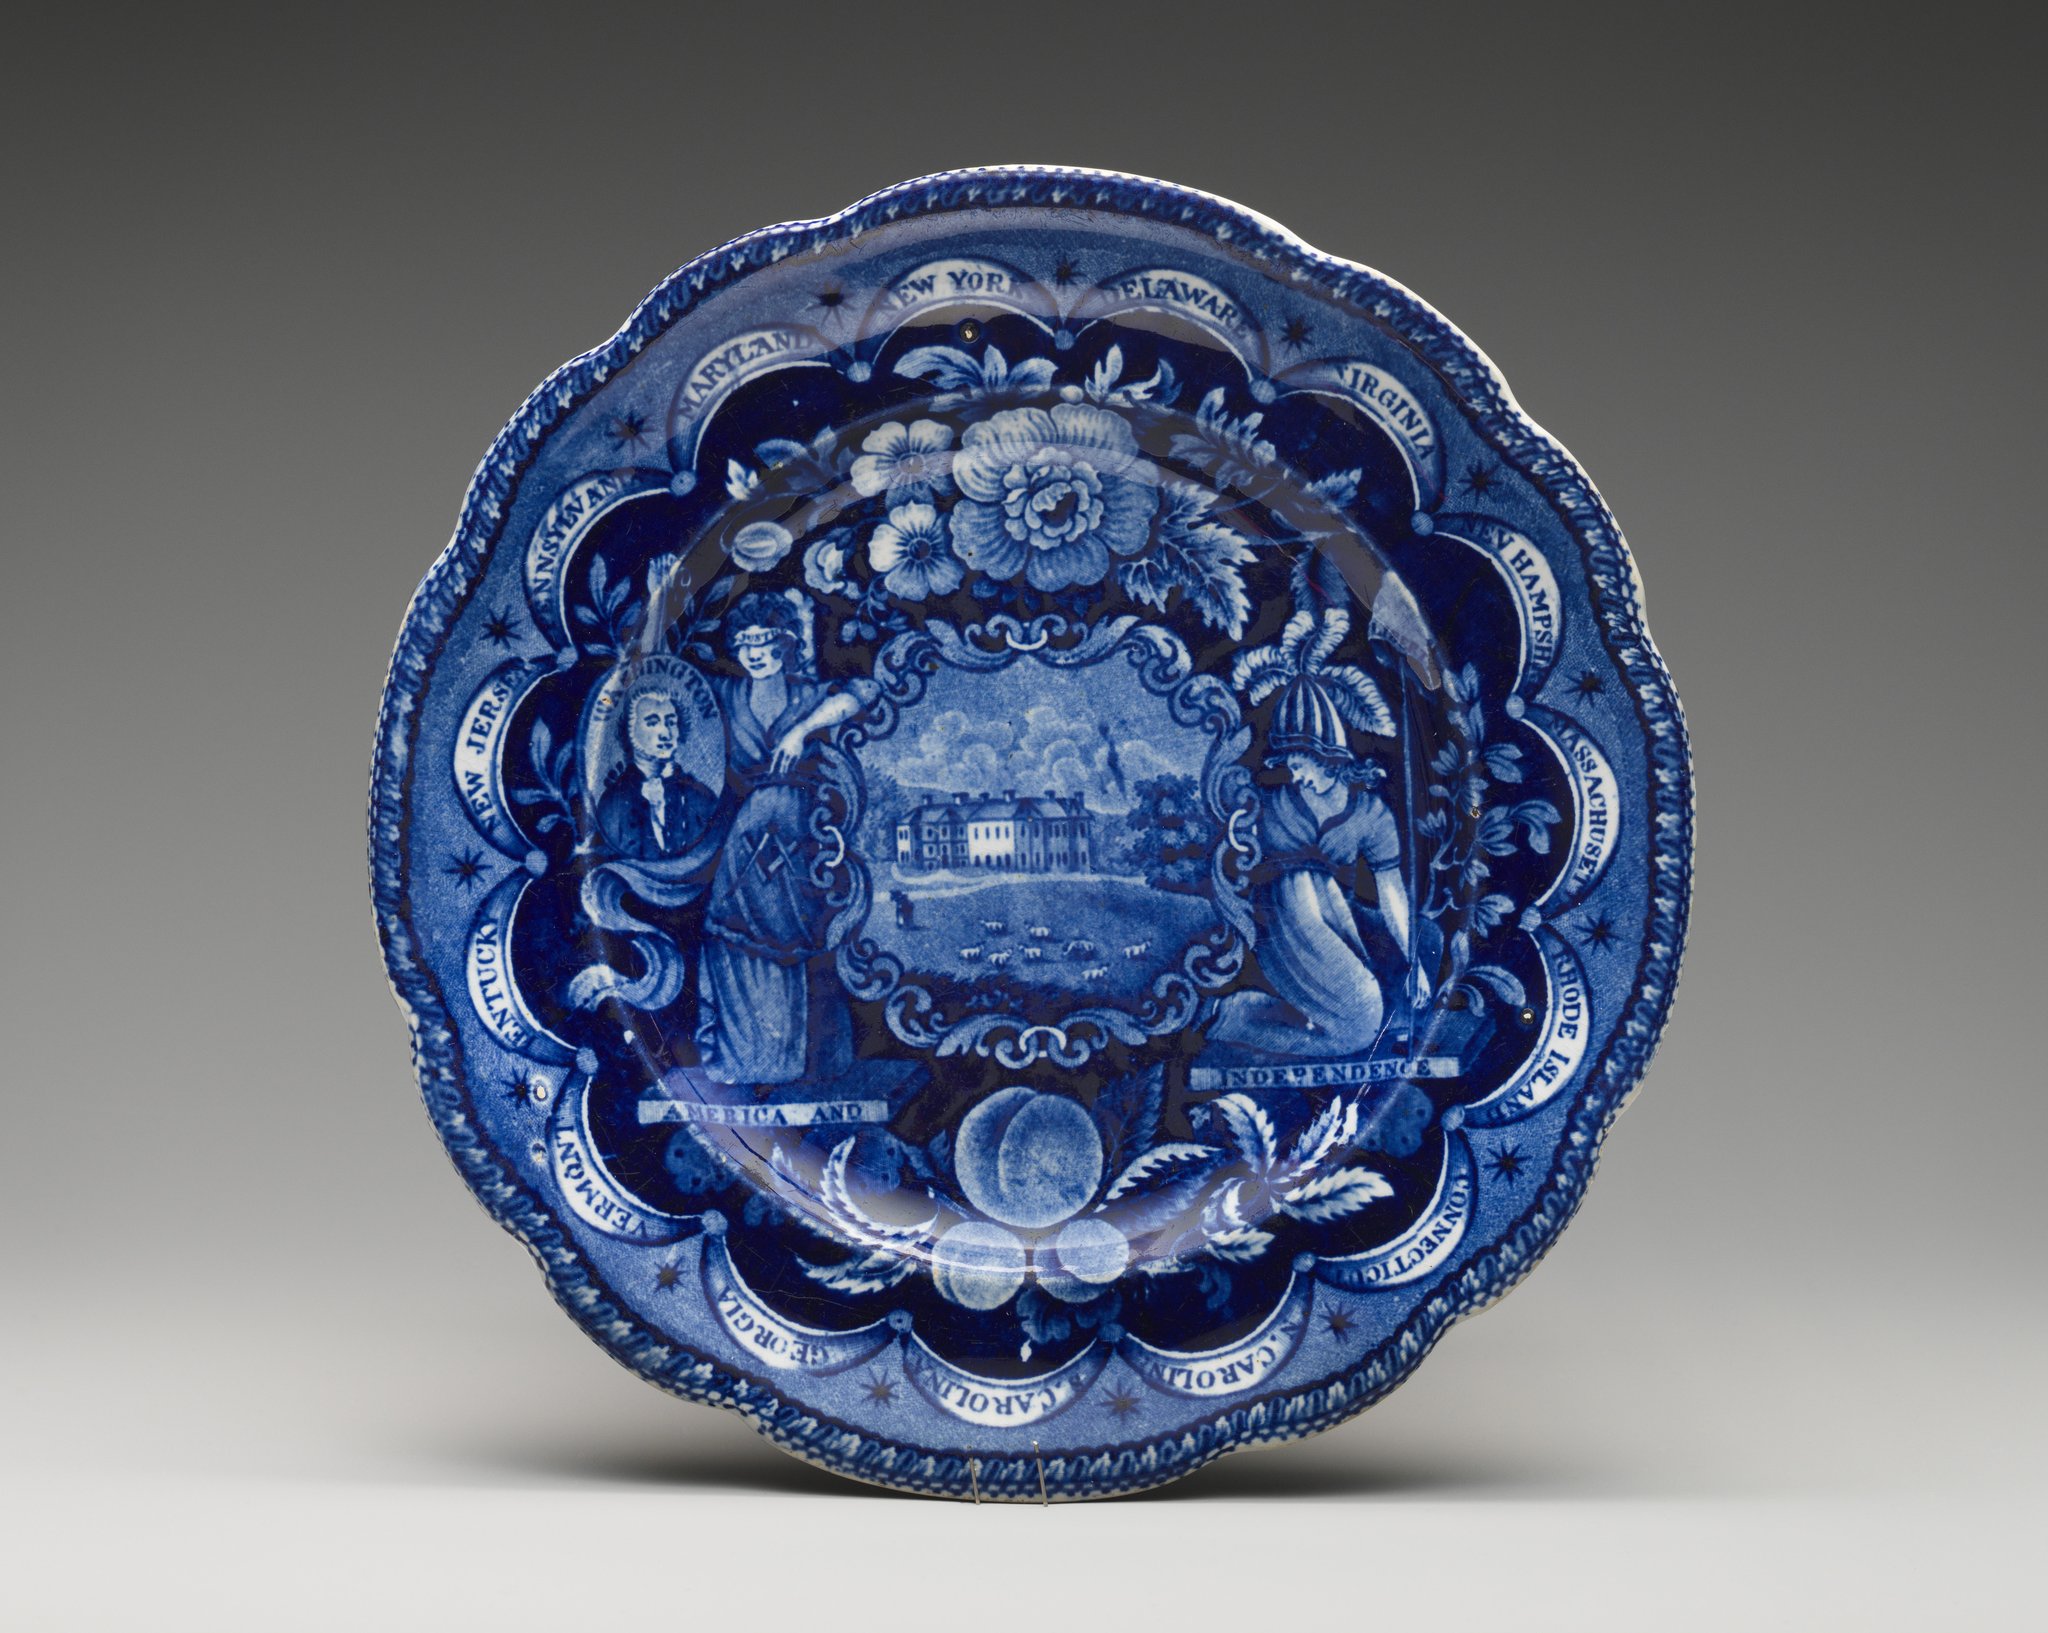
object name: plate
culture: british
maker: james and ralph clews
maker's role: maker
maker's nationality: british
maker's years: 1813-1836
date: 1815-1834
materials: earthenware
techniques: transfer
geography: england